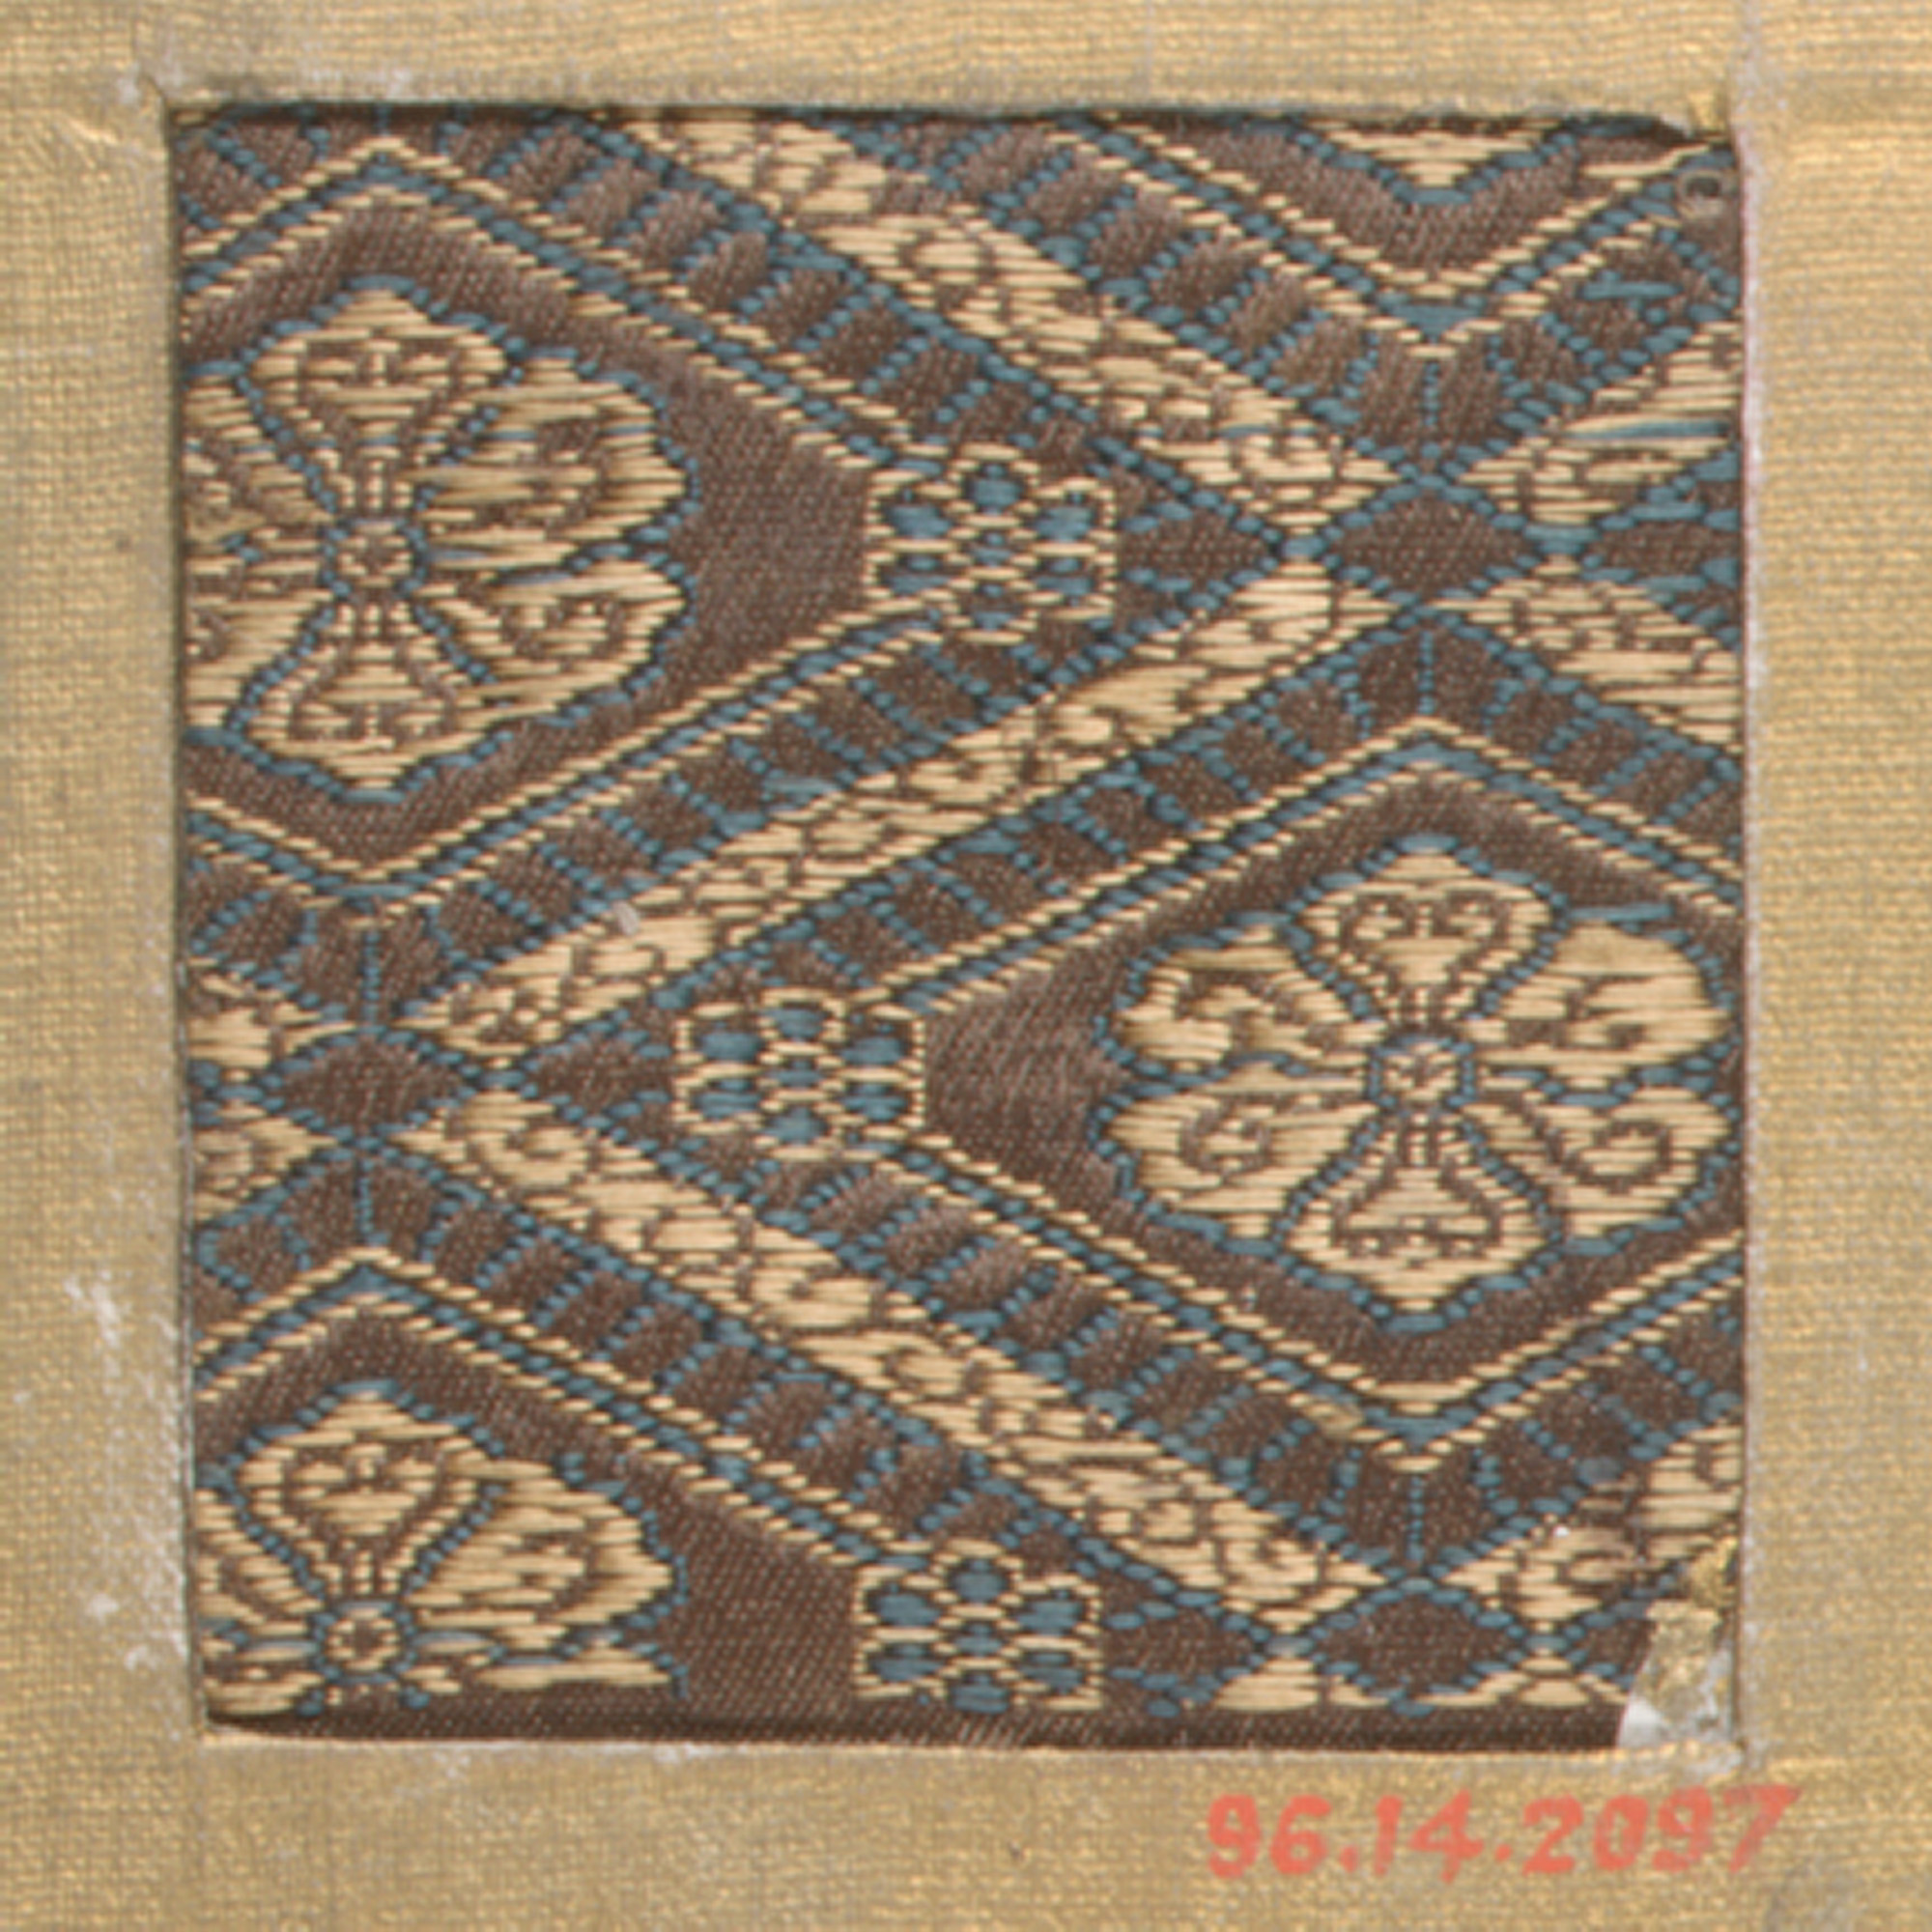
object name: piece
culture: japanese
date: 1701-1900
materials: silk